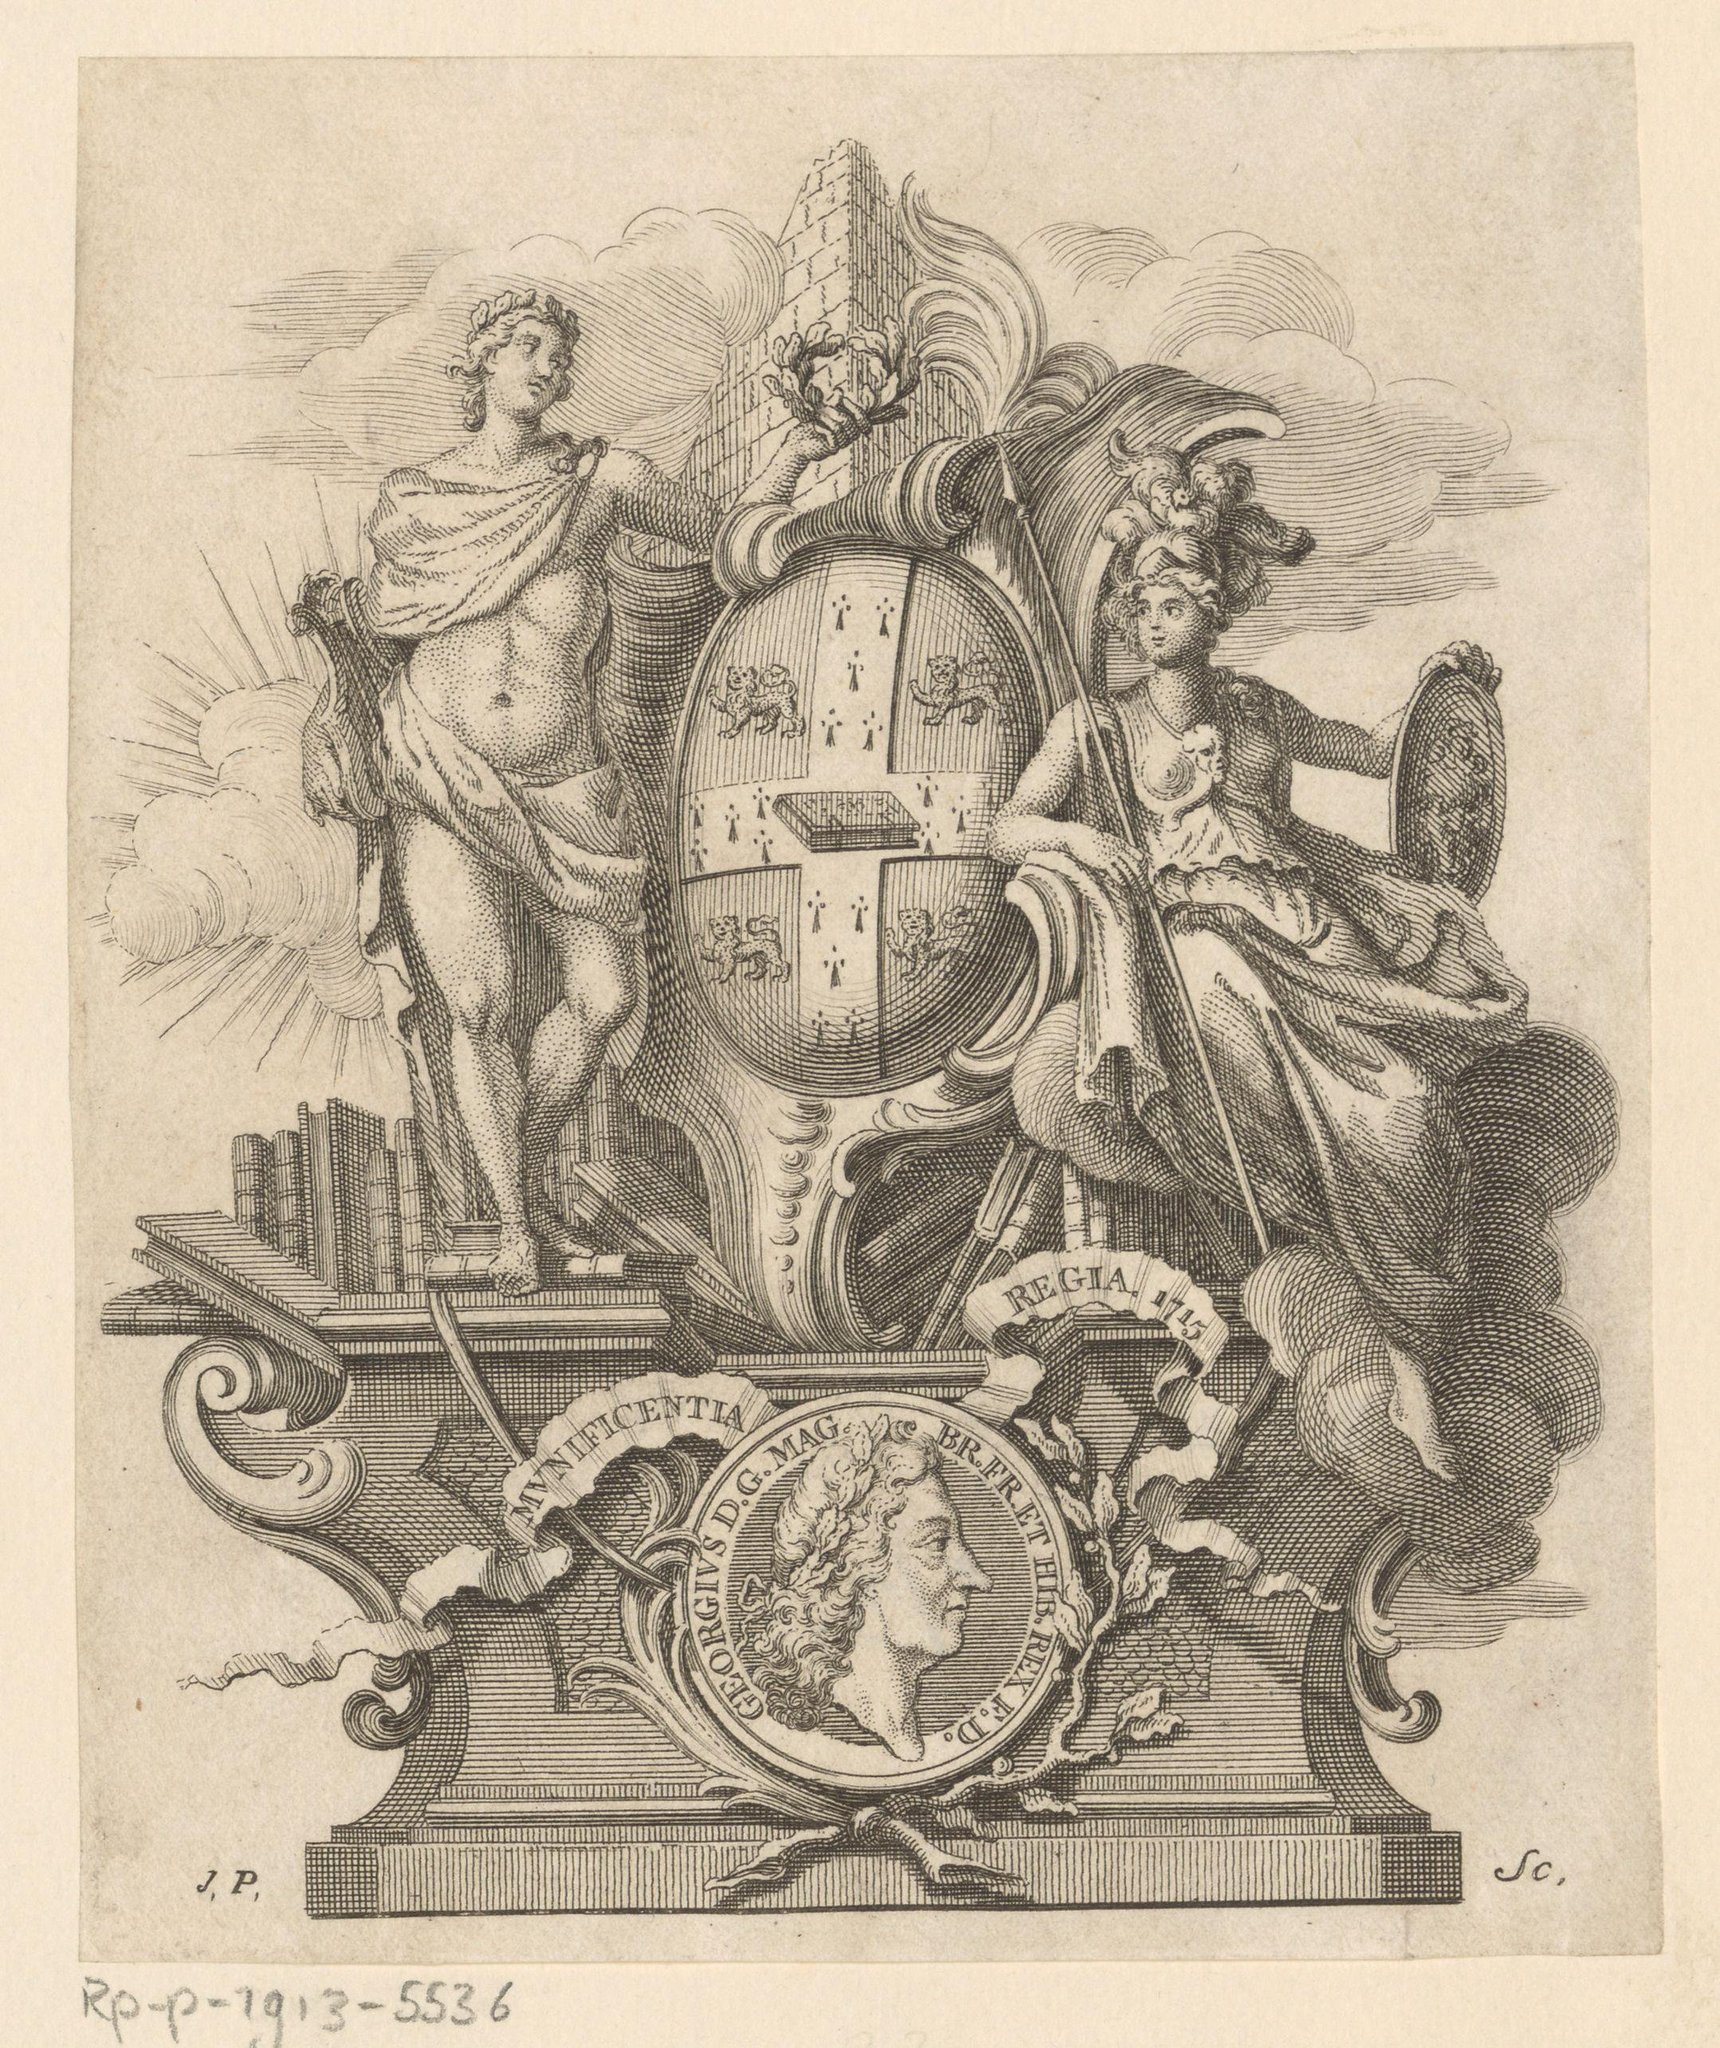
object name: bookplate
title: Ex libris van Cambridge University Library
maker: john pine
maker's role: print maker, publisher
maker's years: 1690-1756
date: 1715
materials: paper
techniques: engraving, etching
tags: george i (koning van groot-brittannië en ierland), armorial bearing, heraldry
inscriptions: collector's mark: Lugt 2760, collector's mark: Lugt 2233